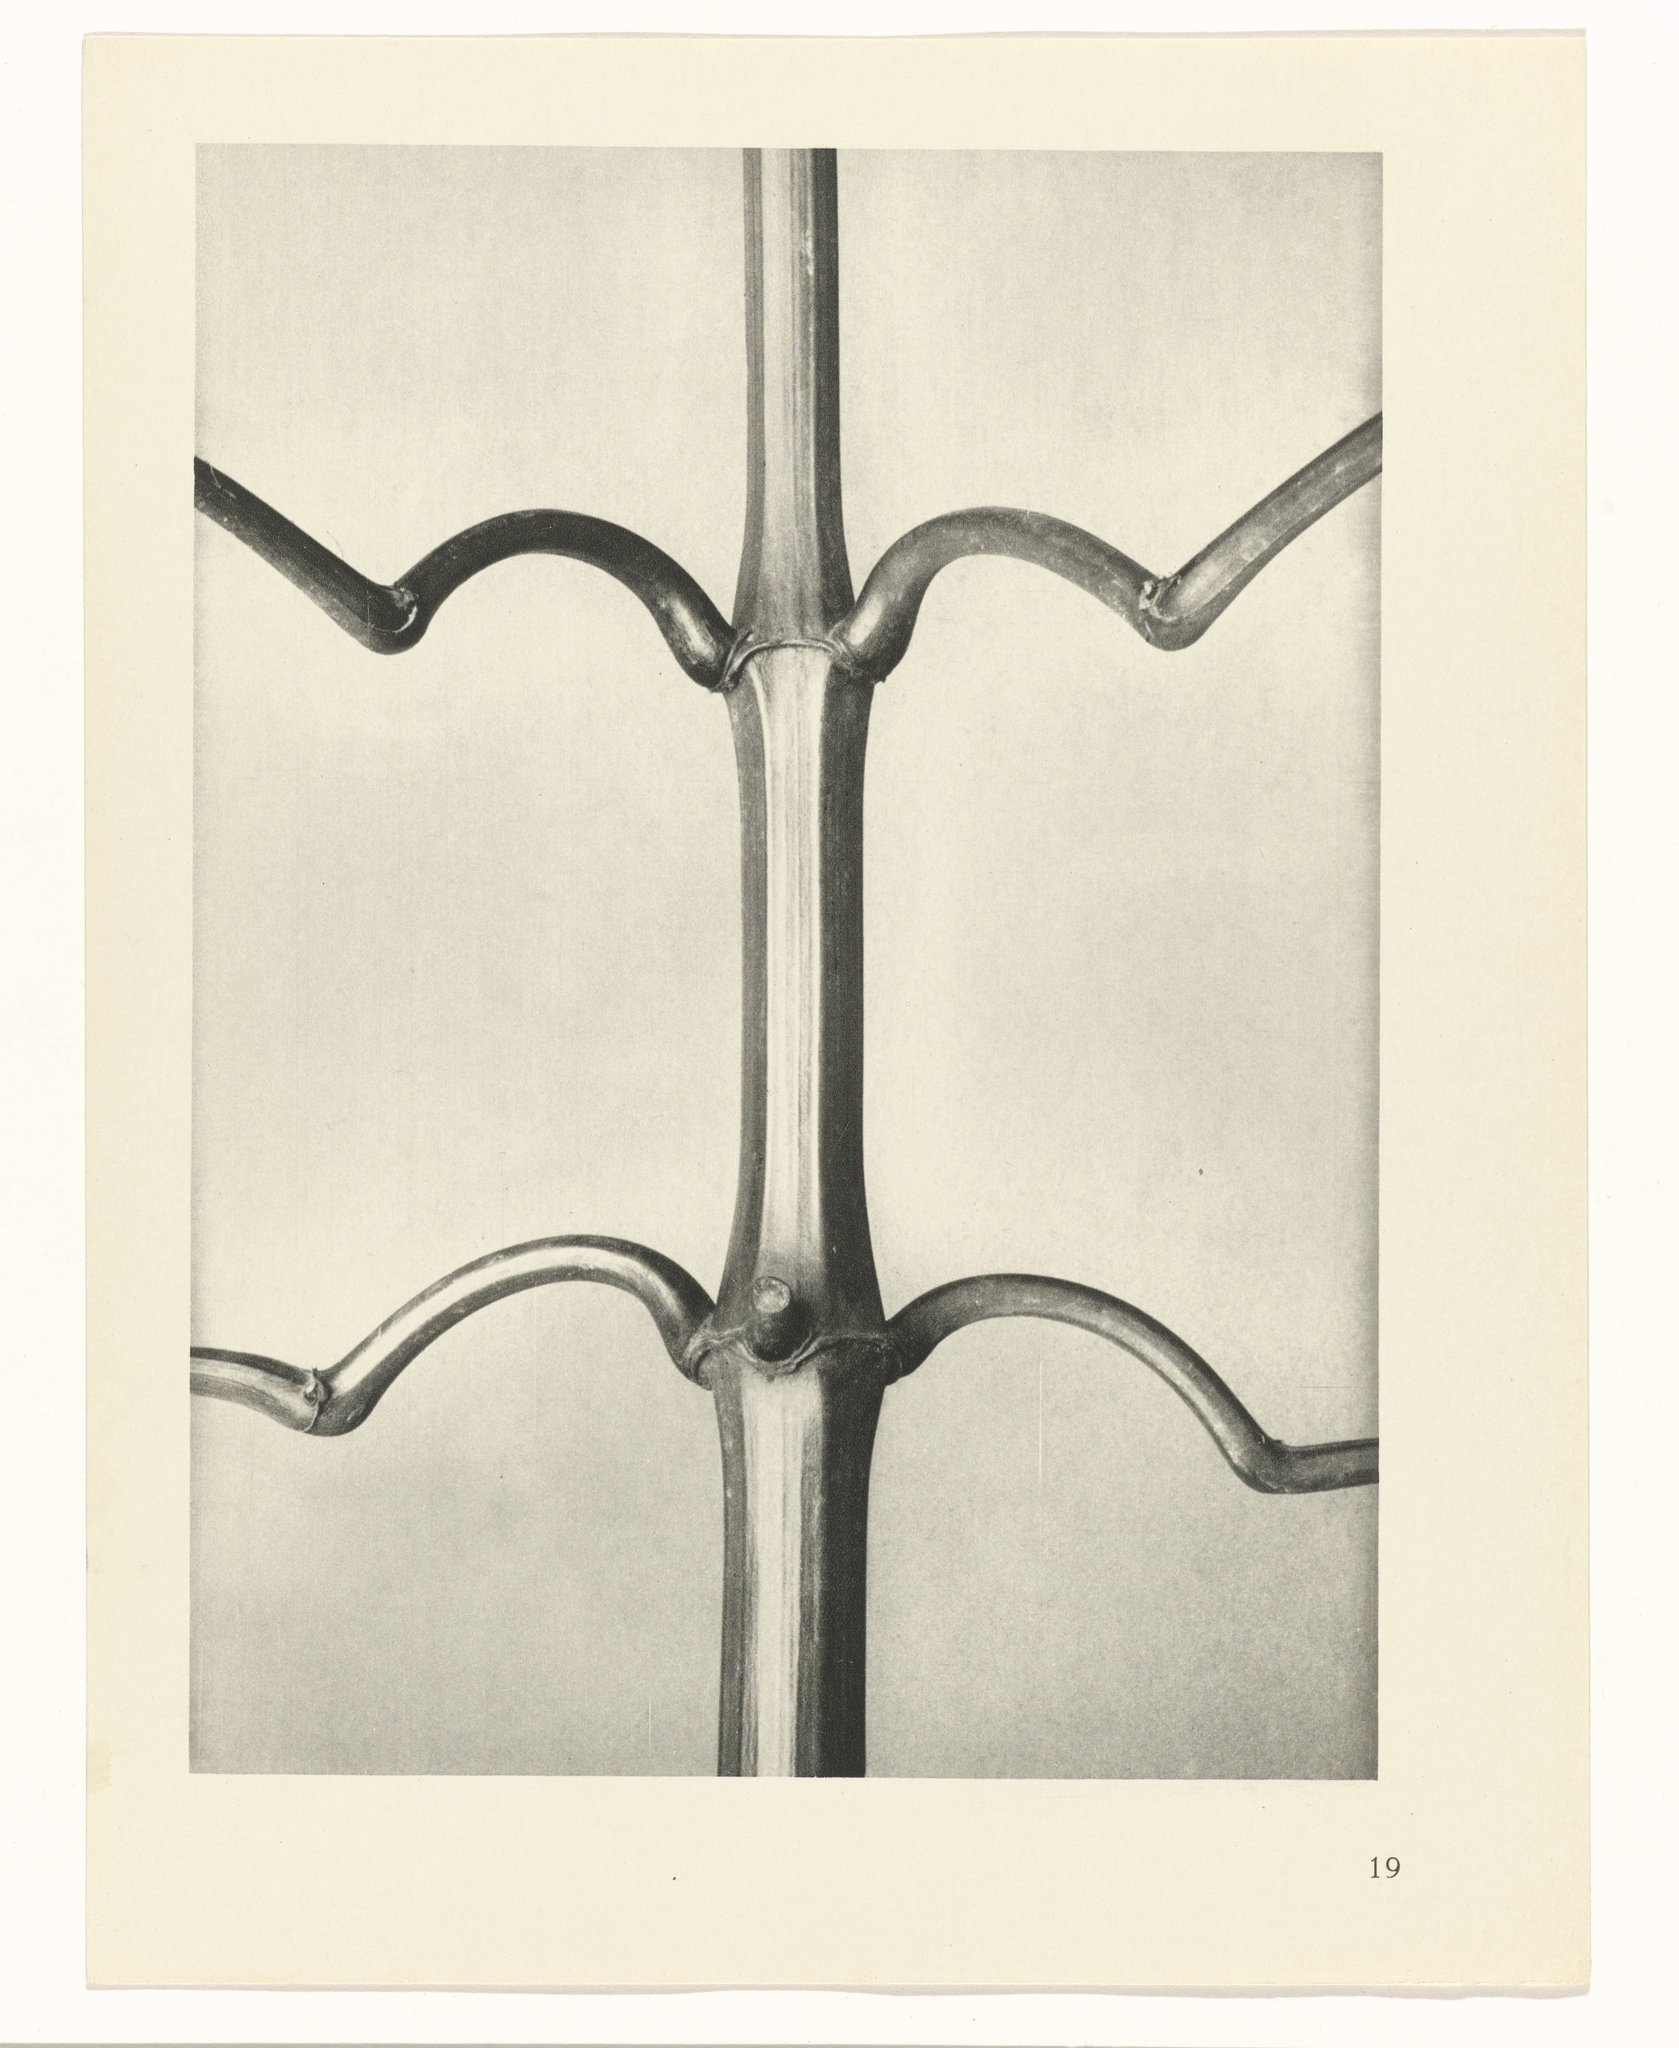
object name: photograph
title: Urformen der Kunst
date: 1928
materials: ink, paper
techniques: rotogravure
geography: berlin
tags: plants (in general)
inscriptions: number: ‘19’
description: facher Vergrößerung. Afkomstig uit losbladige uitgave.